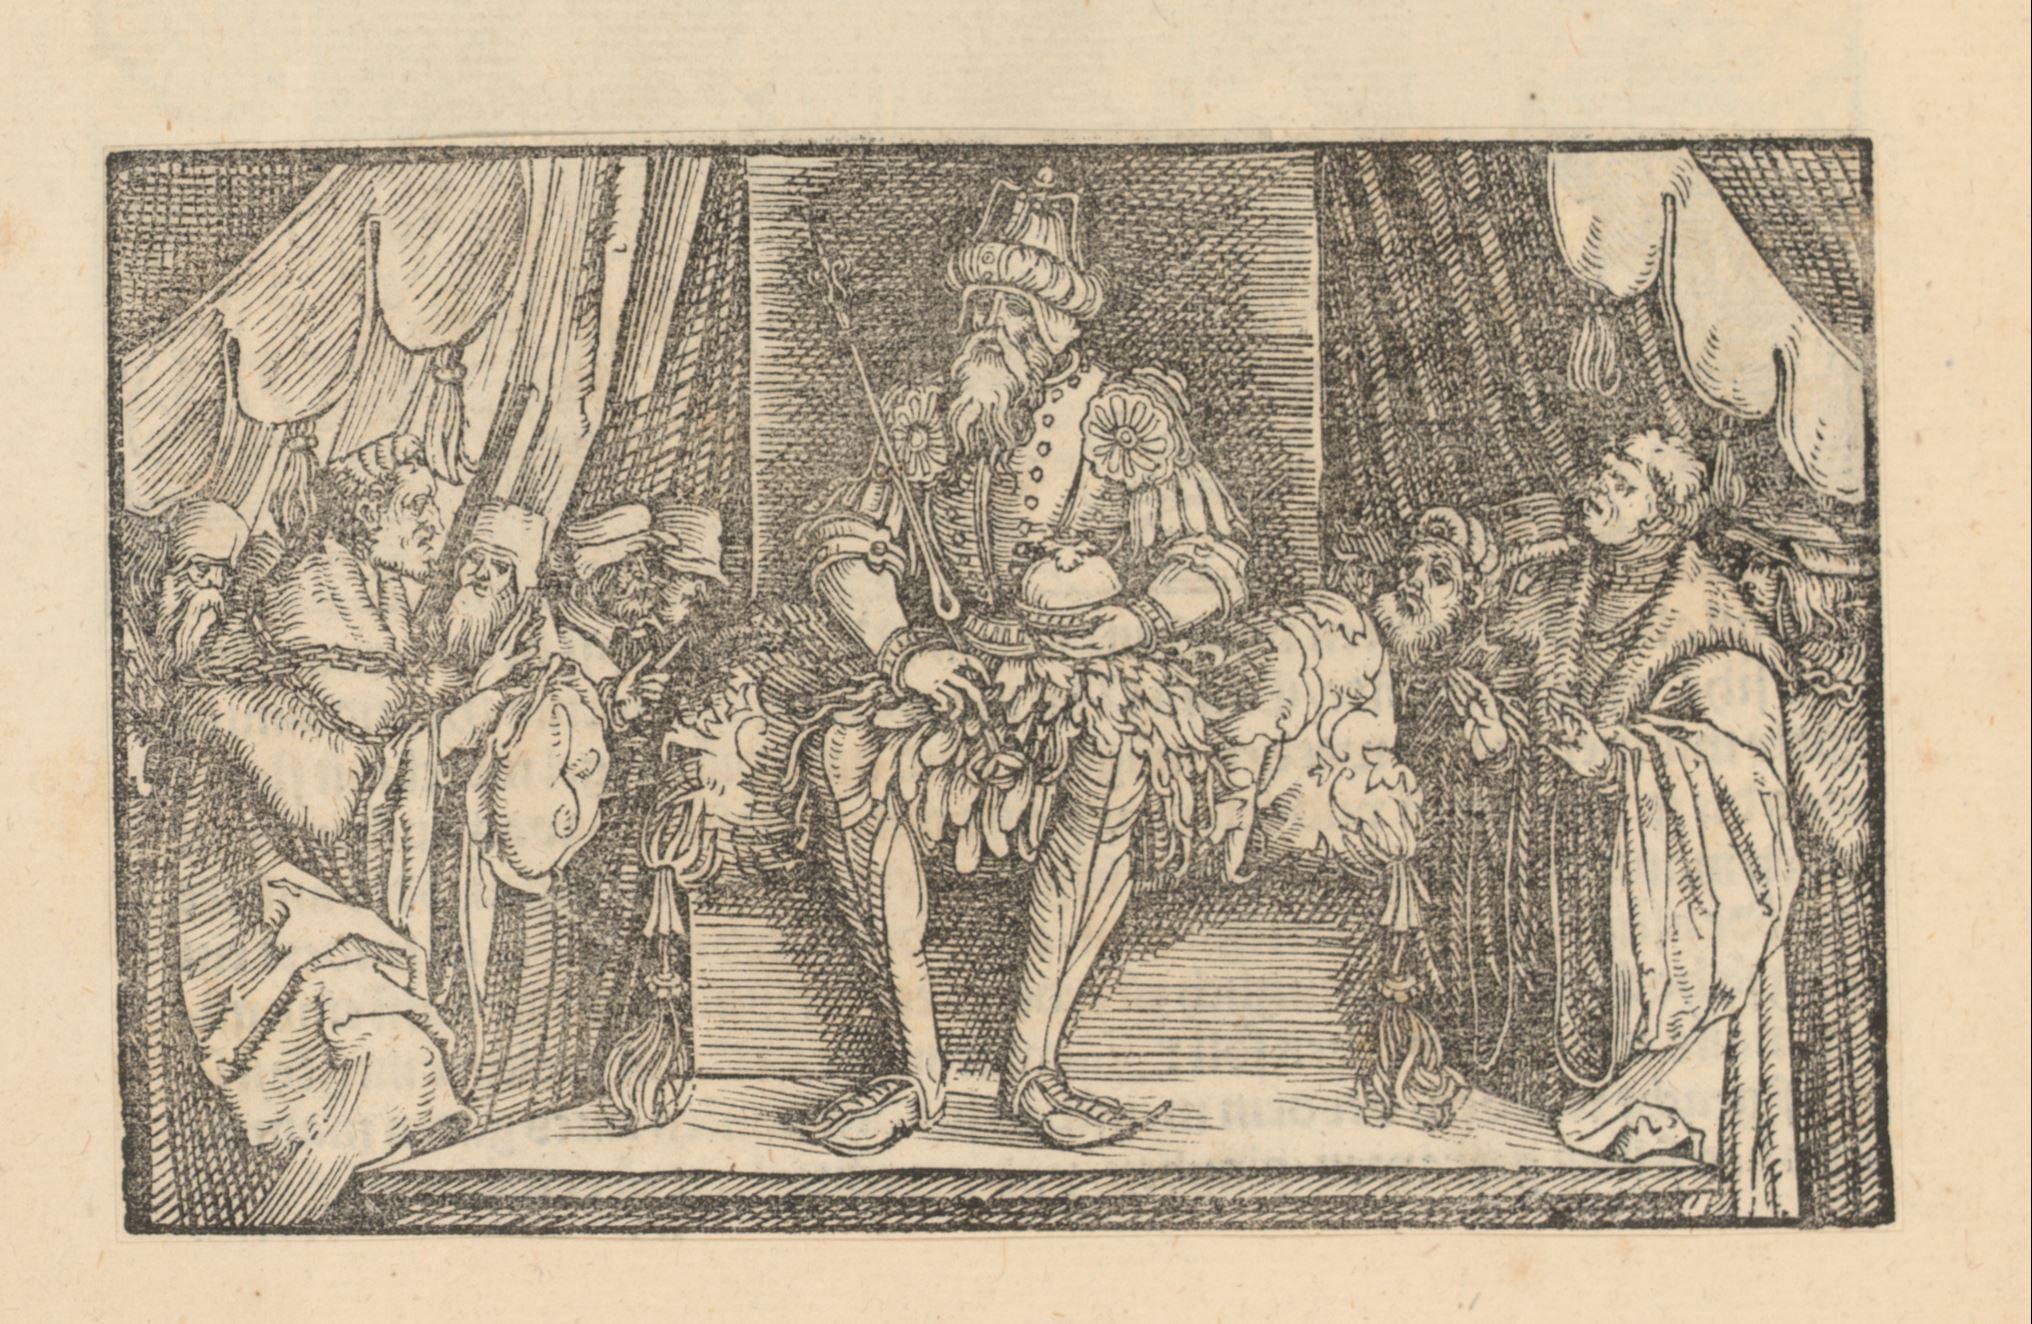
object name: album leaf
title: Heerser op zijn troon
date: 1514-1531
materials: paper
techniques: letterpress printing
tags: canopy, baldachin, (story of) c. julius caesar, dictatorial government, tyranny; 'tirannide' (ripa)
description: Deze prent is gebruikt in: Cicero, Marcus Tulius. Officia M.T.C. Ein Buch so Marcus Tullius Cicero der Römer zu seynem (...). [Vertaald uit het Latijn door] Johann von Schwarzenberg. Augsburg: Heinrich Steiner, 1531.